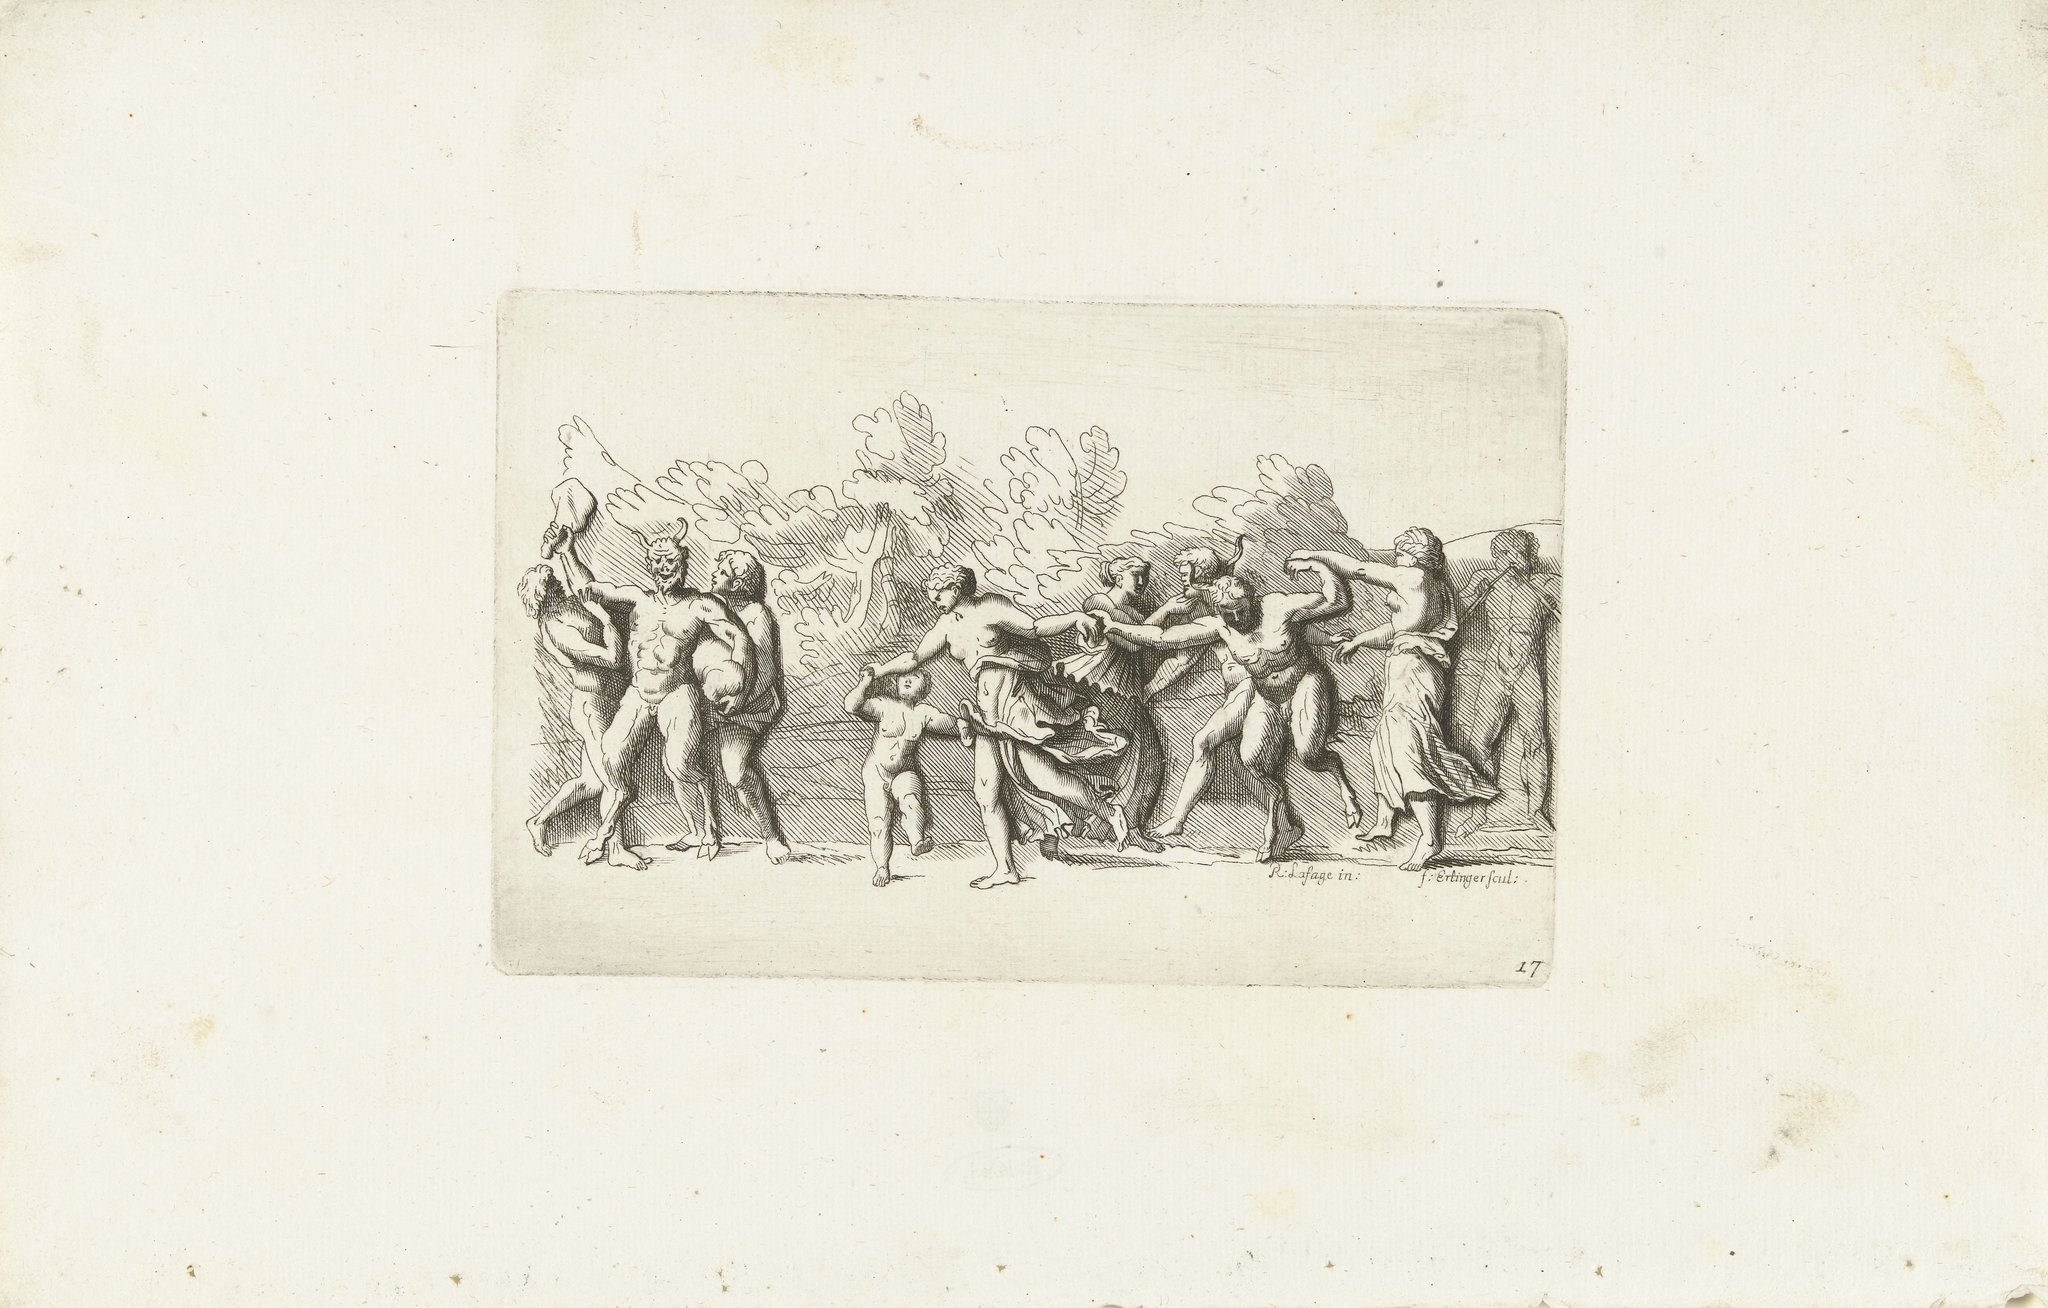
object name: print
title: Dansende bacchanten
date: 1652-1707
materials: paper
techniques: engraving, etching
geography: paris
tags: veneration of bacchus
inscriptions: collector's mark: Lugt 2760, collector's mark: Lugt 2228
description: Dansende mannen, vrouwen, kinderen en satyrs.